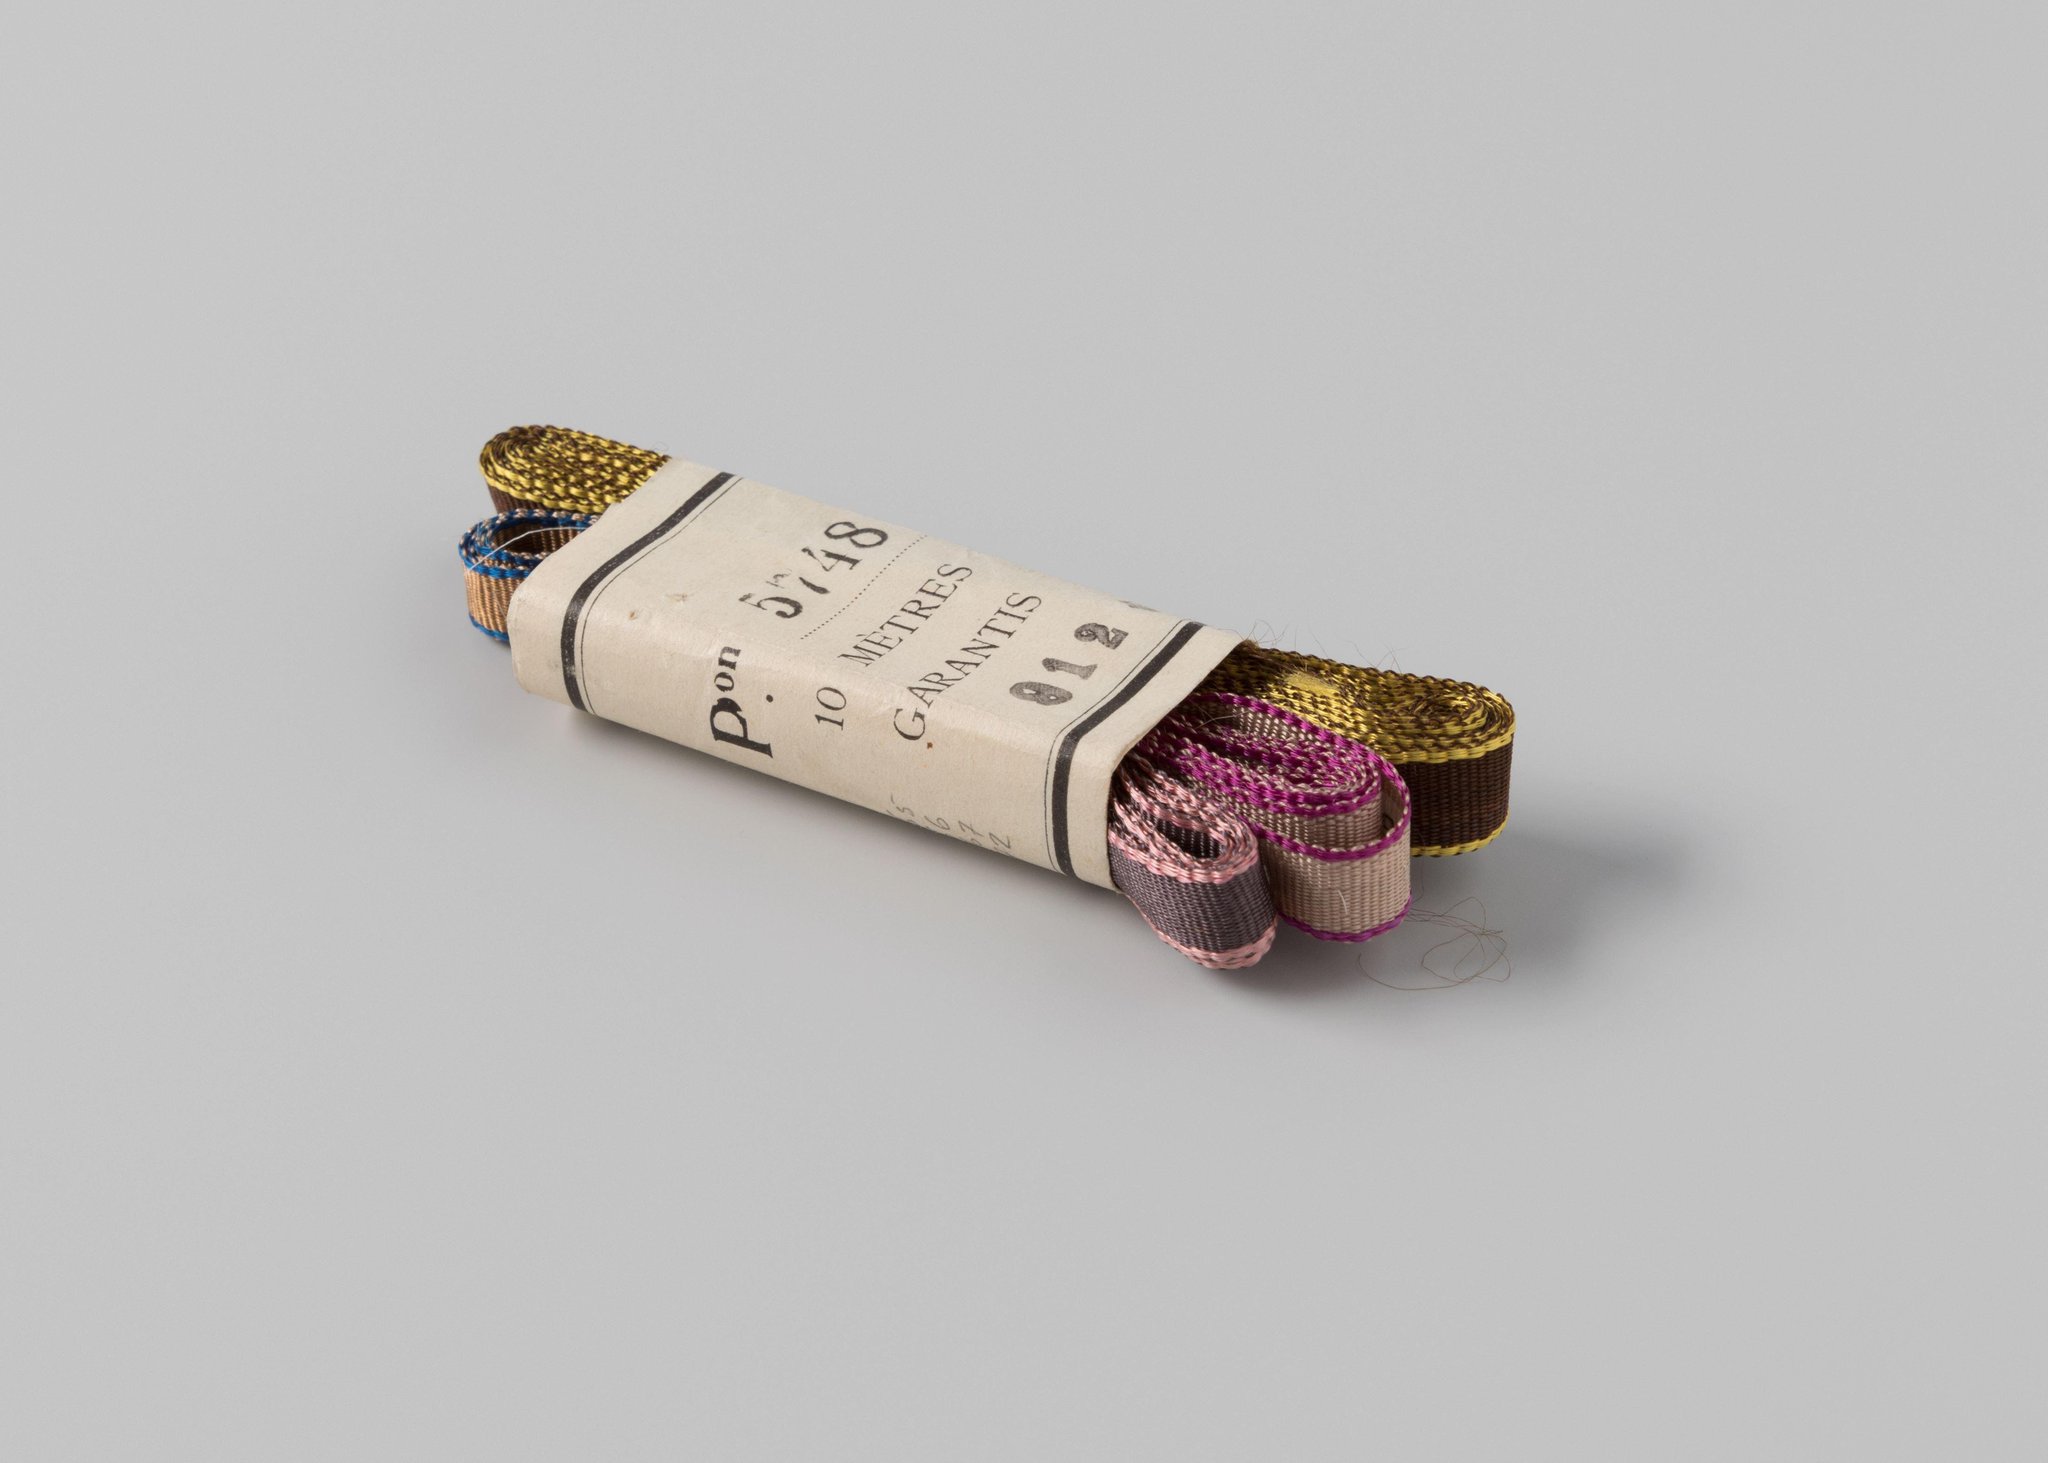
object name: braid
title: Lint, grijs, aan beide zijden paars afgebiesd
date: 1890-1935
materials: textile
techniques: weave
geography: france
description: Lint, grijs, aan beide zijden paars afgebiesd.